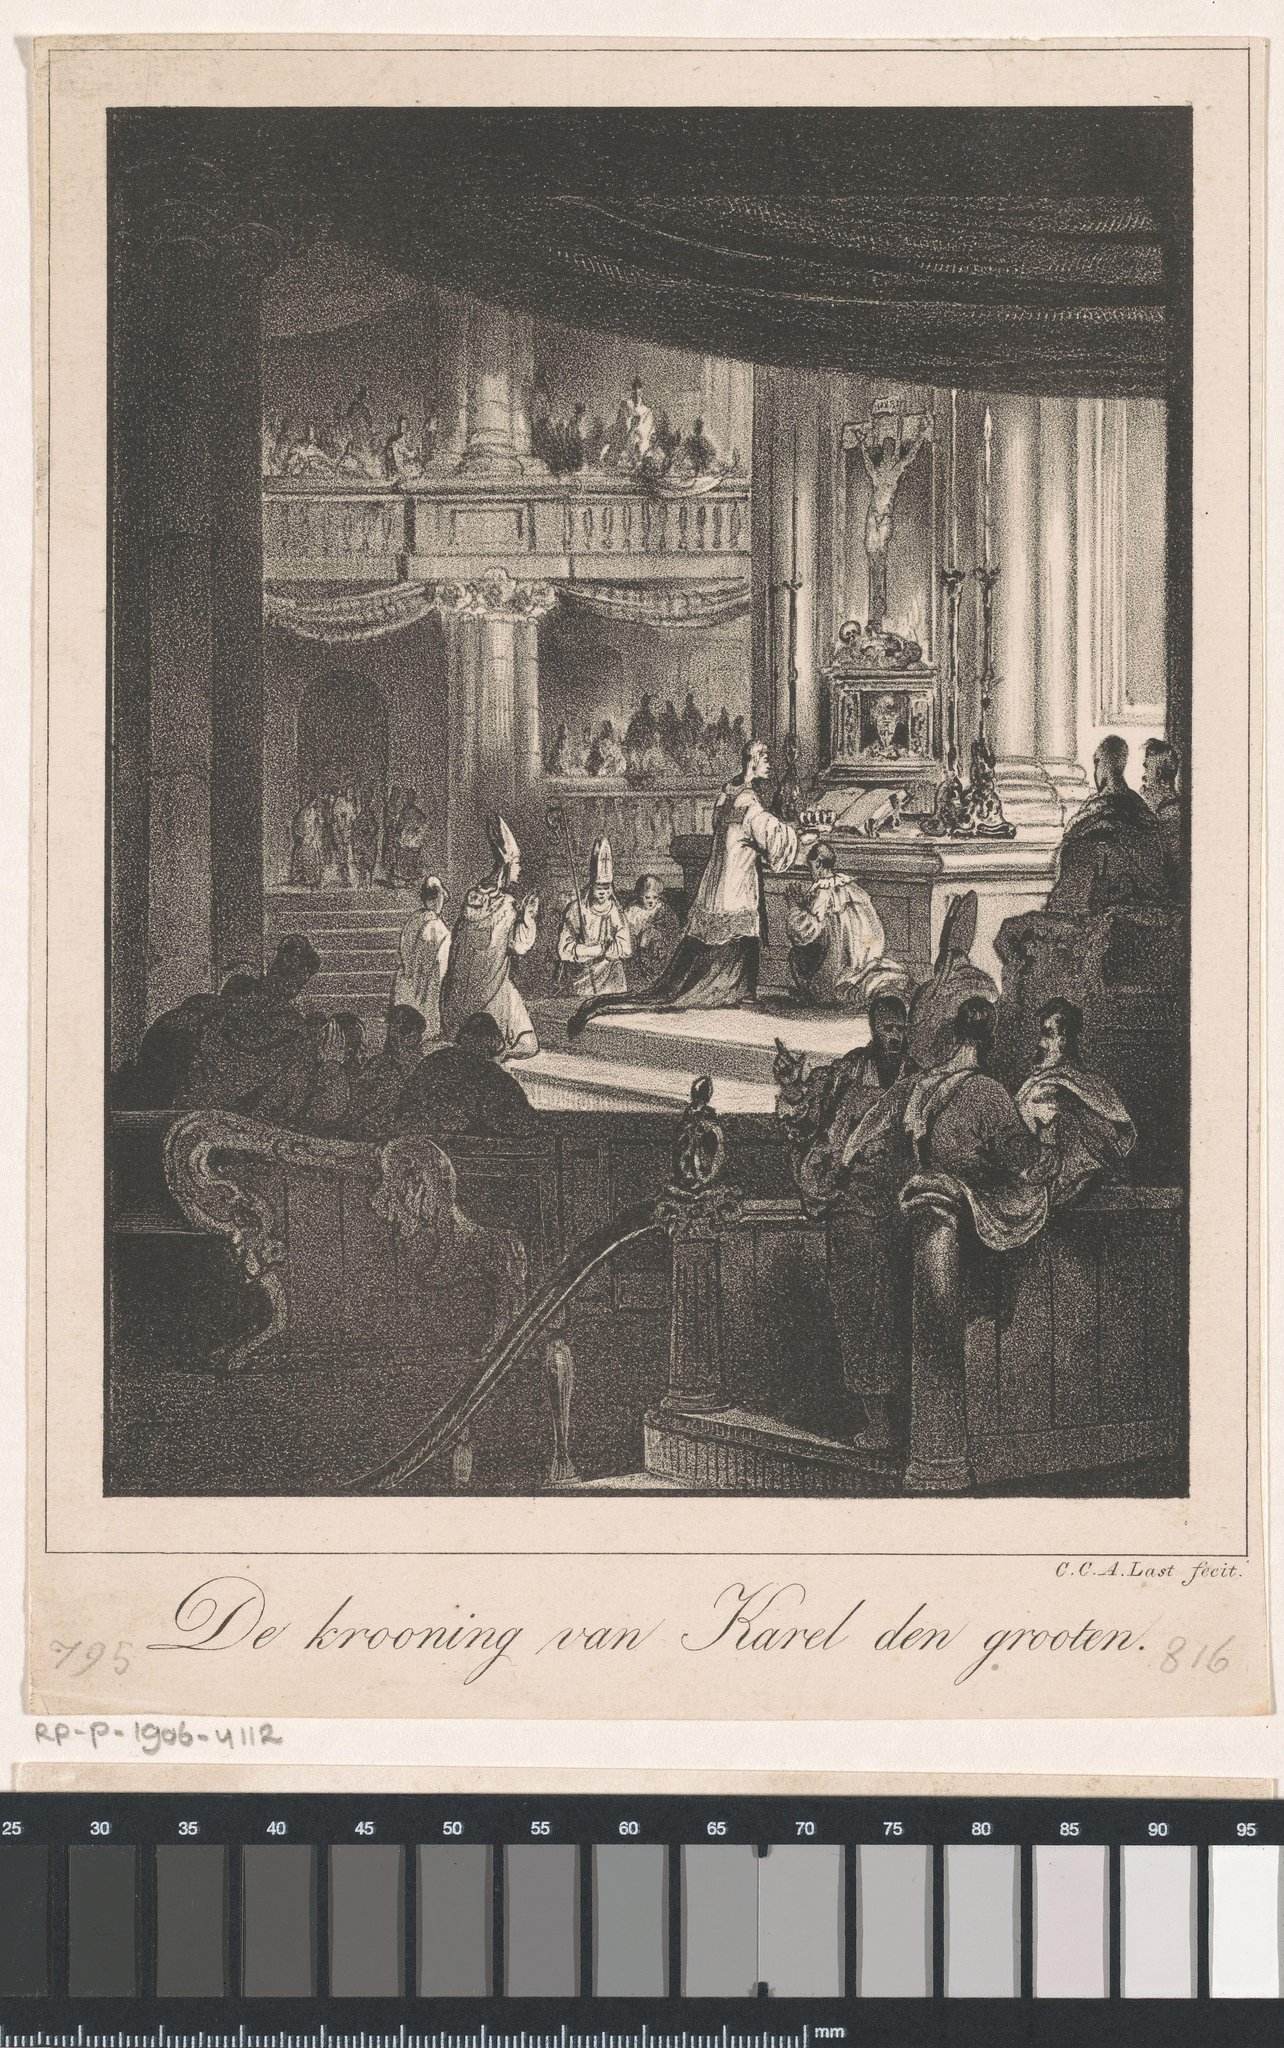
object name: book illustration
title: De krooning van Karel den grooten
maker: carel christiaan antony last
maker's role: print maker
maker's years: 1808-1876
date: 1835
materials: paper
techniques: lithograph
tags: charlemagne (holy roman emperor), during the coronation, rome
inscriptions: collector's mark: Lugt 2228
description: Illustratie uit: Heijningen, H. van Taferelen uit de geschiedenis der Christelijke kerk. Den Haag: S. de Visser, 1833, p. 180.